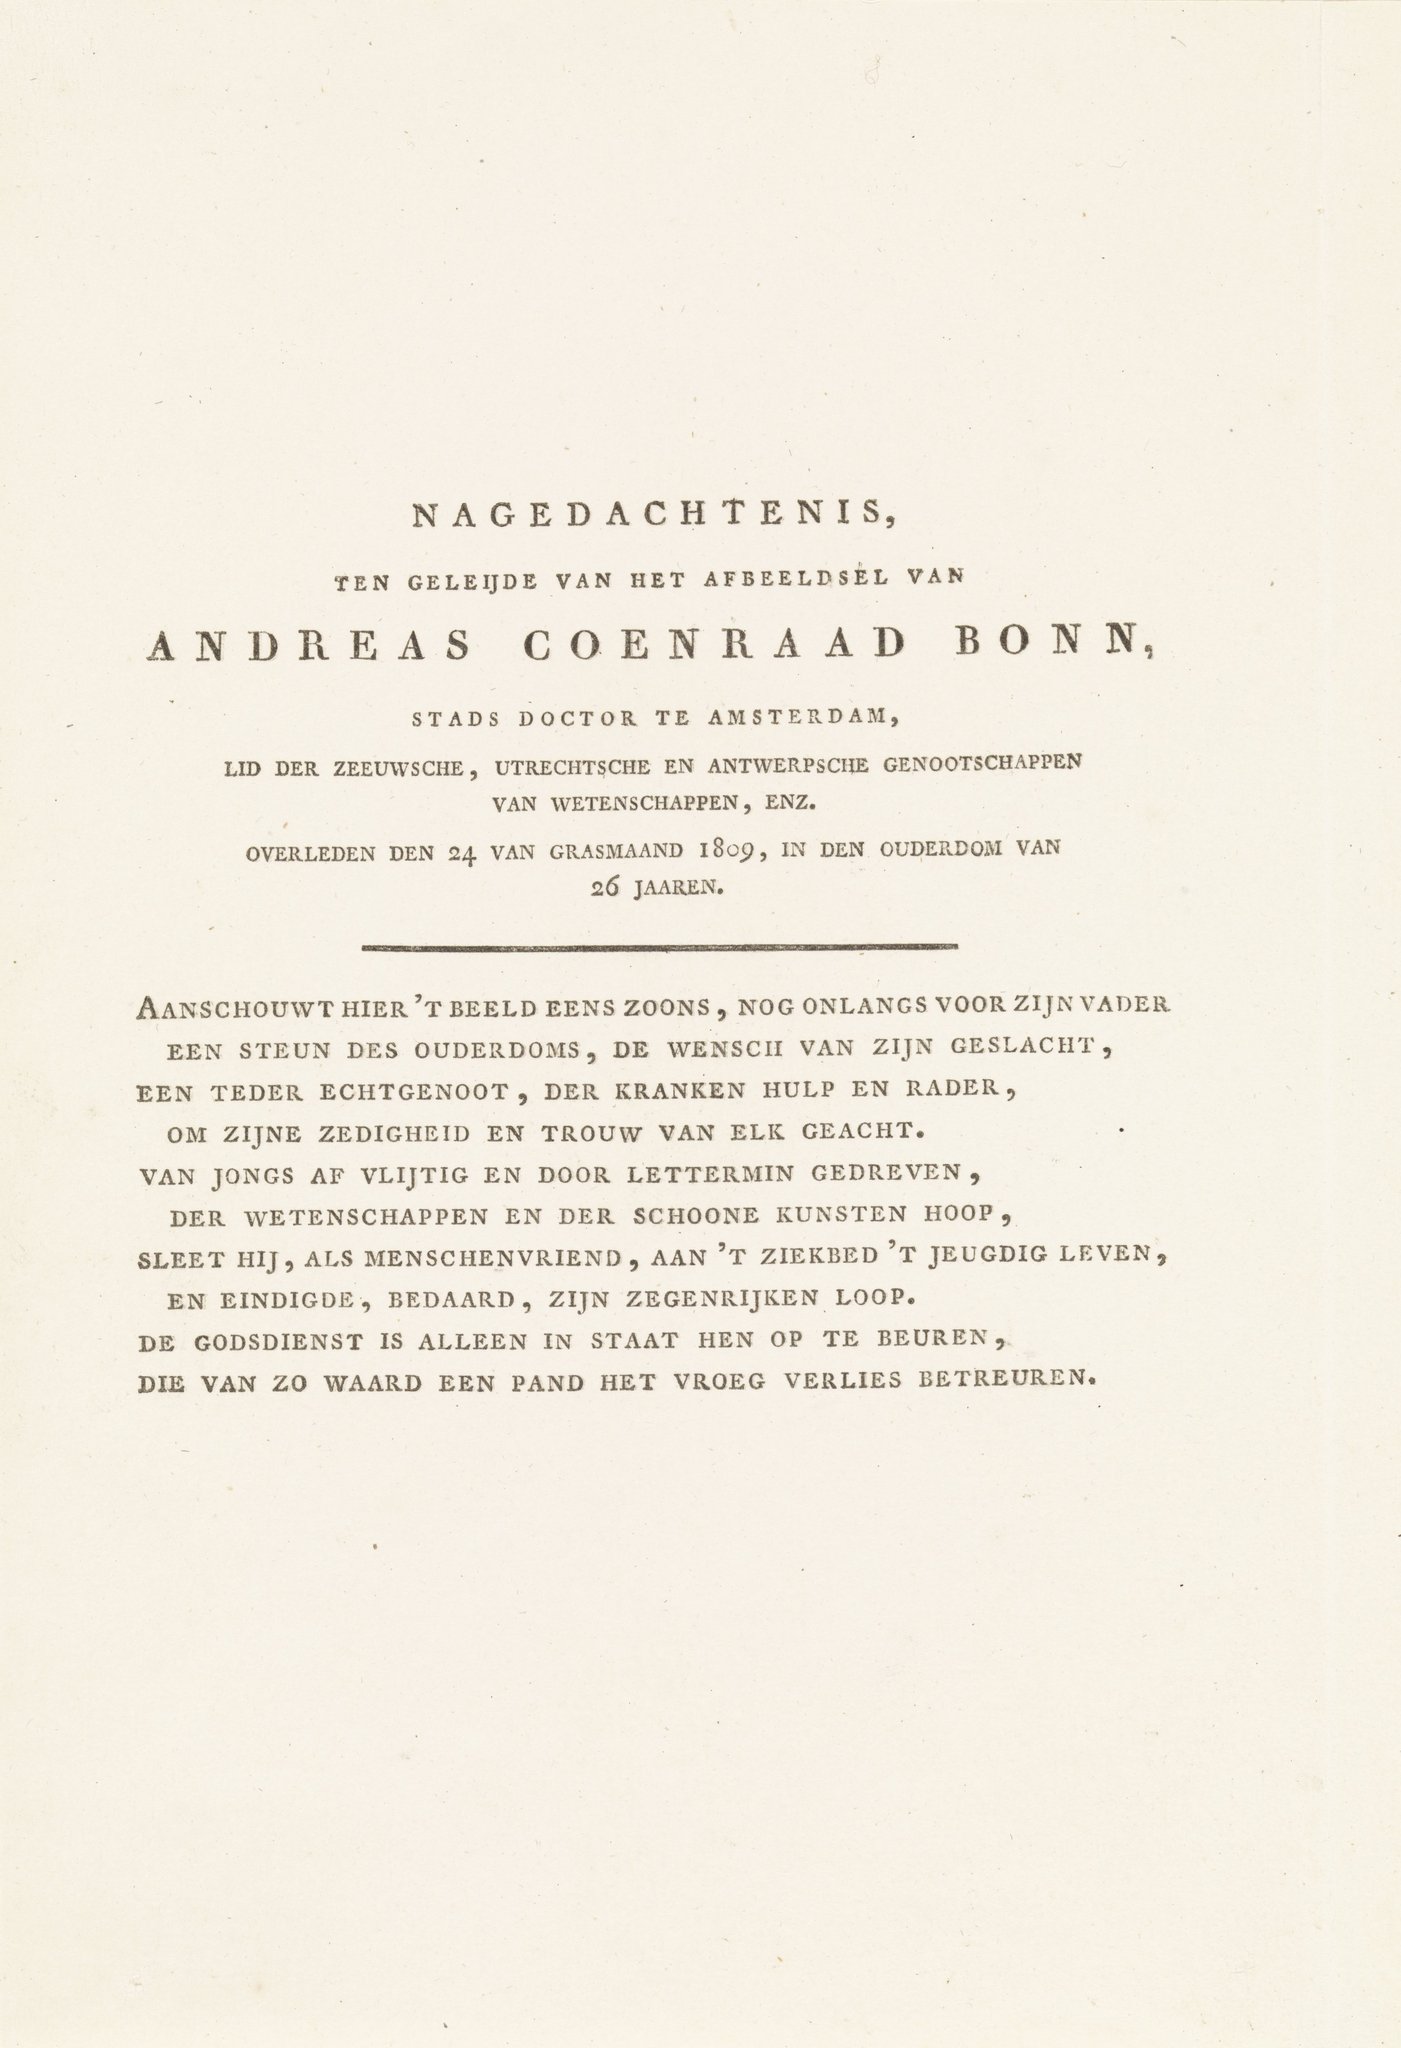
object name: poem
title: Lofdicht op Andreas Coenraad Bonn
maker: ludwig gottlieb portman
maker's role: print maker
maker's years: 1772-1828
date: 1787-1828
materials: paper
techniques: letterpress printing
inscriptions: collector's mark: Lugt 2228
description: Tienregelig gedicht in het Nederlands, ter nagedachtenis aan de Amsterdamse arts Andreas Coenraad Bonn.